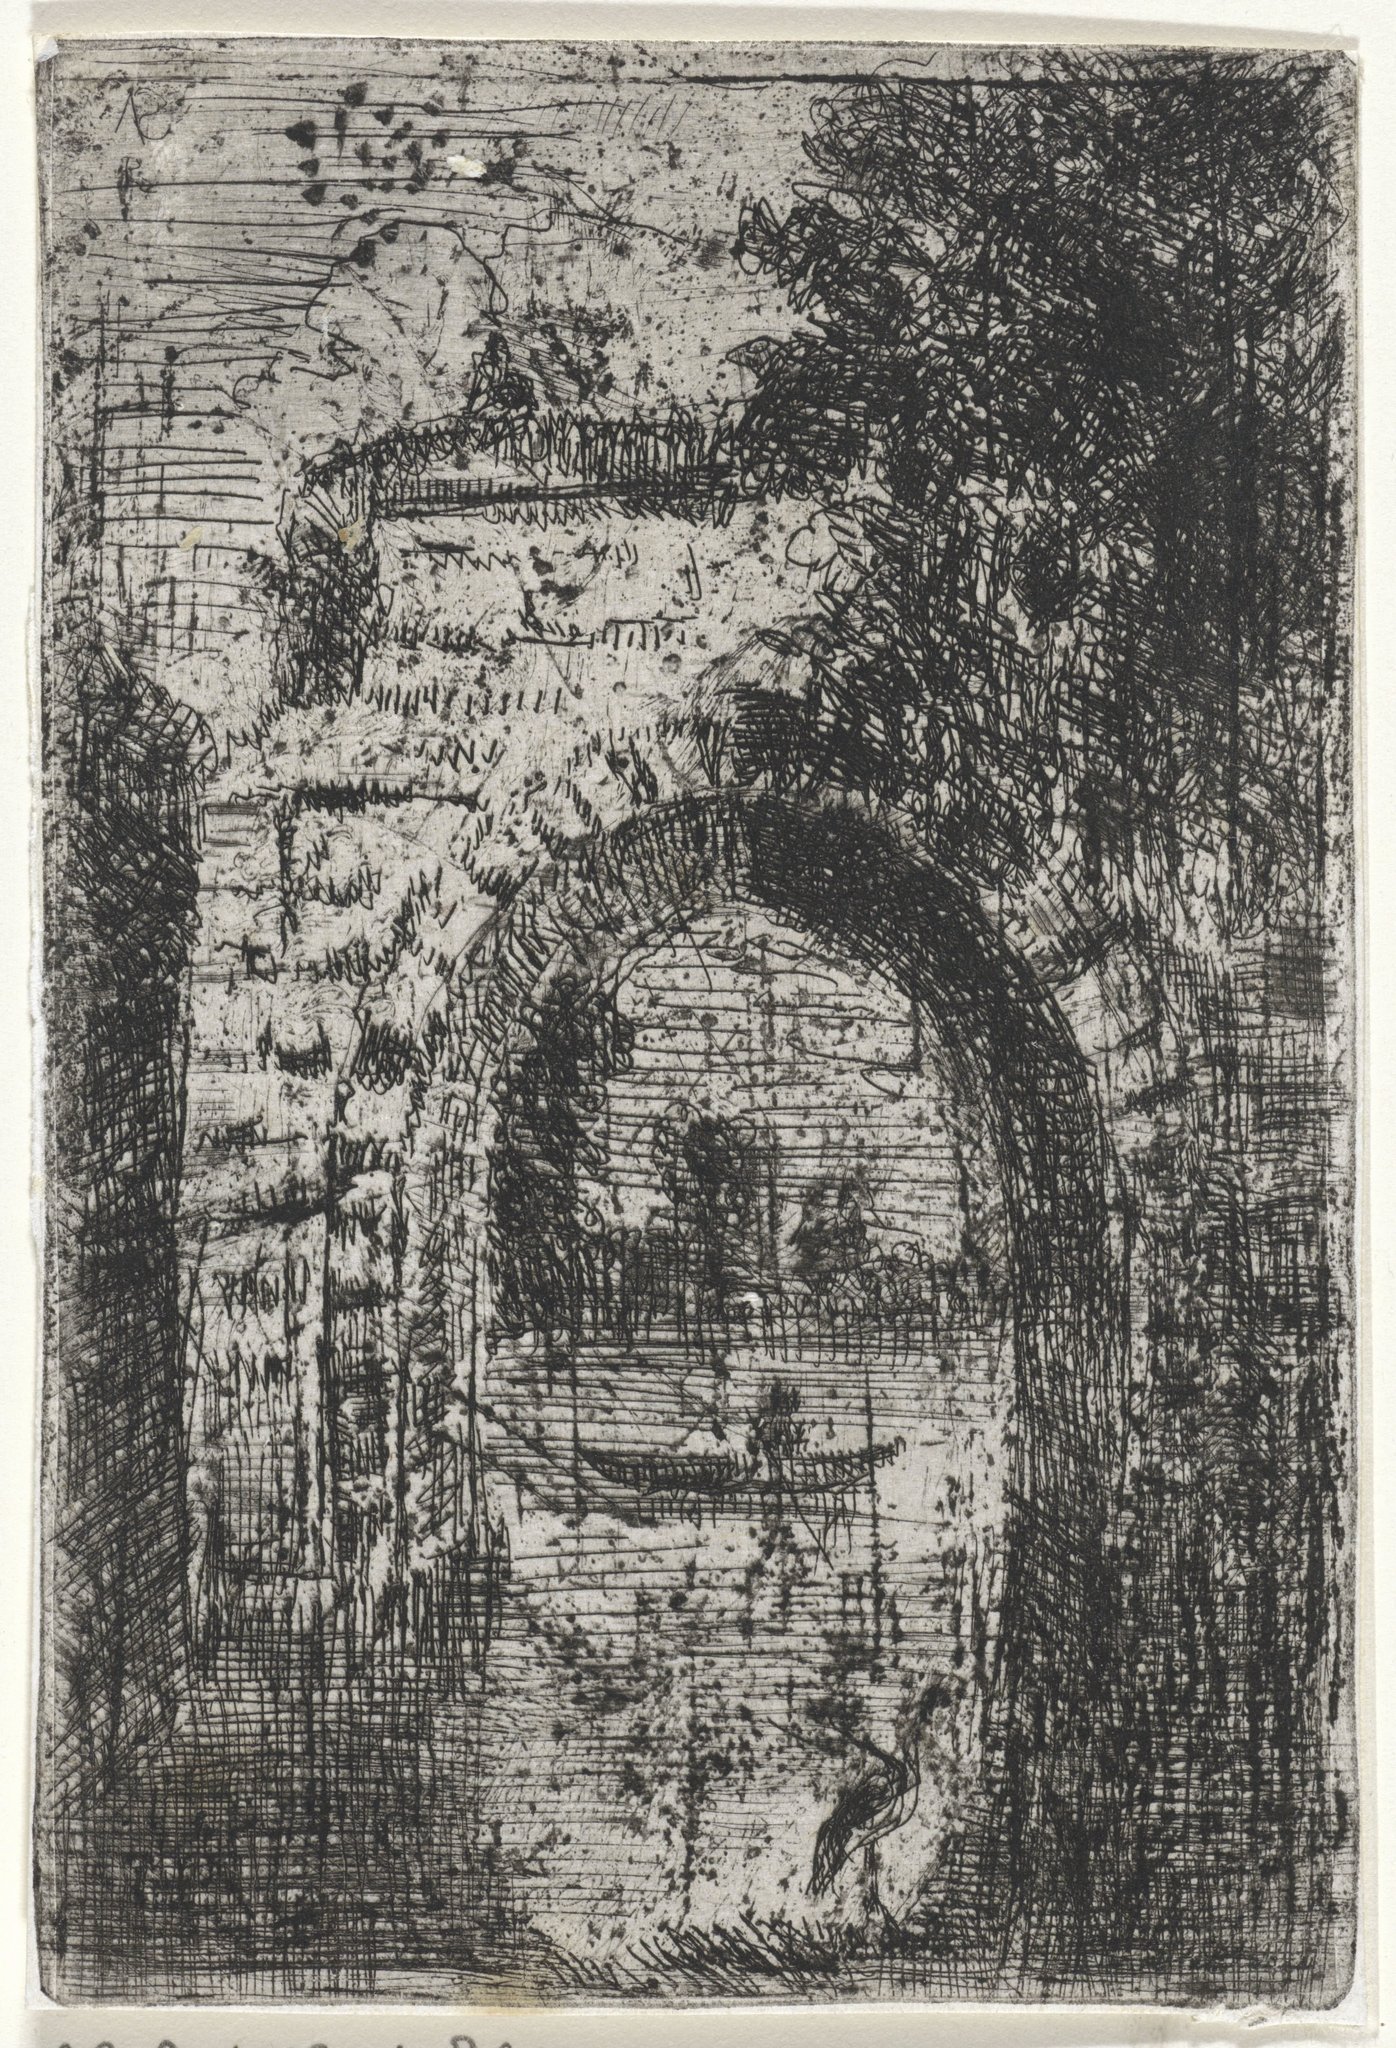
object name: print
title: Doorkijk onder een brug met roeiboot en reiger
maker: arnoud schaepkens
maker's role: print maker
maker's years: 1816-1904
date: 1831-1904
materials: paper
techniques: drypoint, etching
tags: shore-birds and wading-birds: heron, rowing-boat, canoe, etc., bridge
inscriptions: collector's mark: Lugt 2228